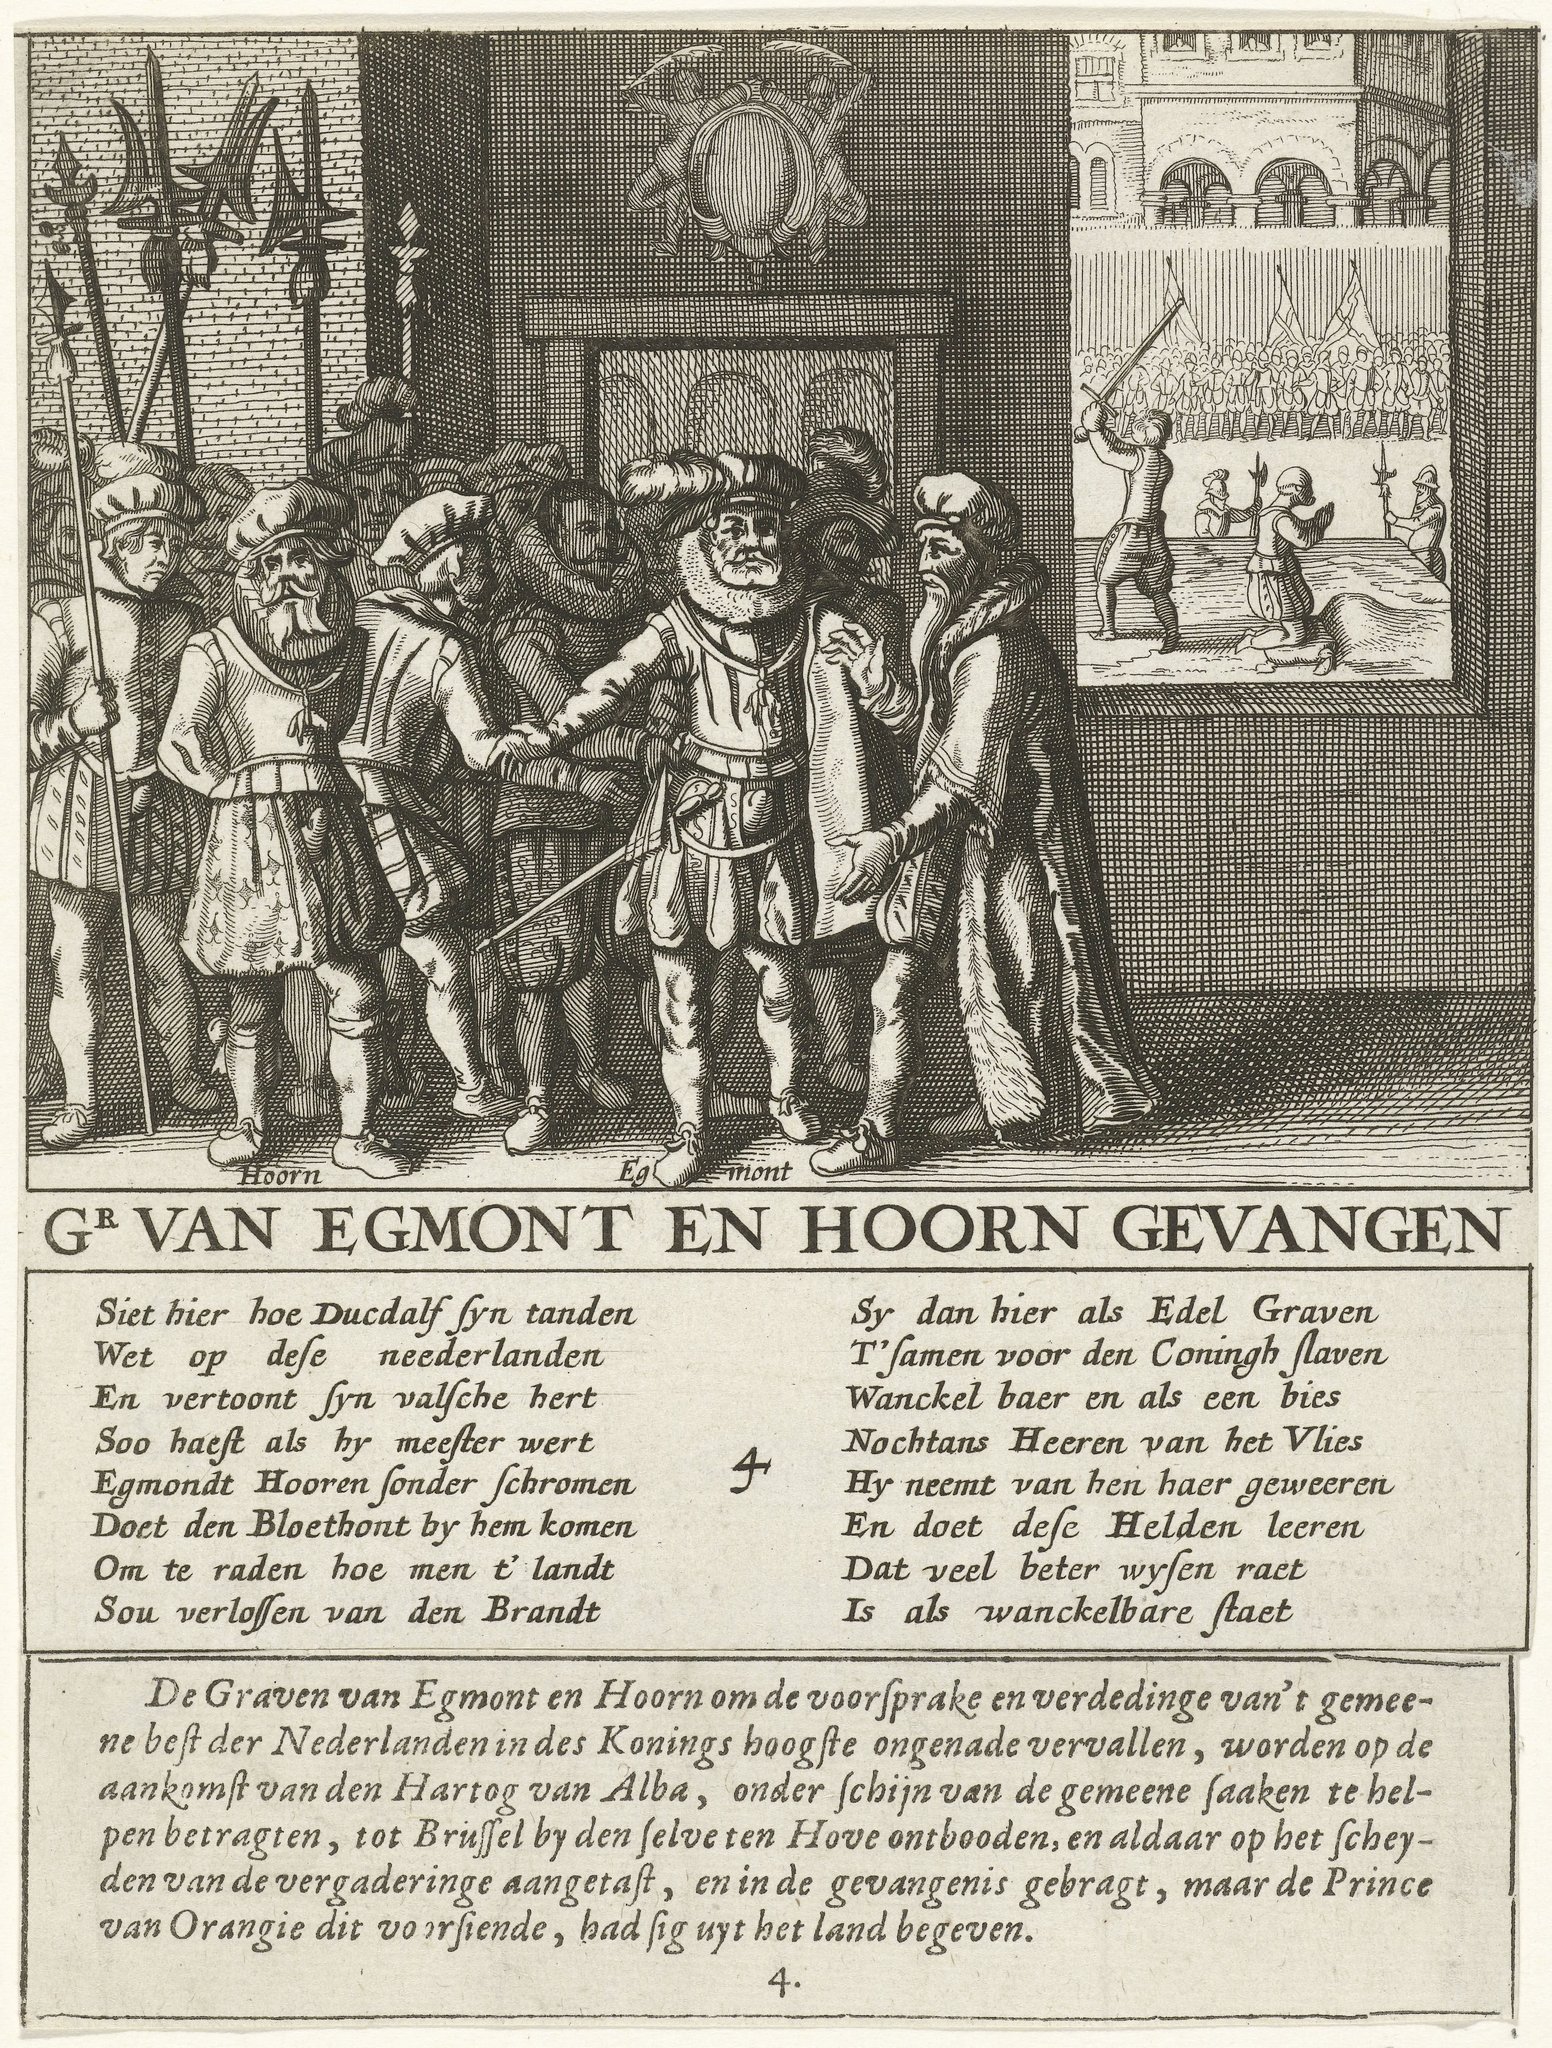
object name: print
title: De Spaensche Tiranye gheschiet in Nederlant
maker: Anonymous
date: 1618-1624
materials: paper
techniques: etching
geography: northern netherlands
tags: fernando álvarez de toledo (3rd duke of alba), brussels, earl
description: Illustratie voor een (onbekende) uitgave van het populaire en vaak herdrukte werk getiteld: De Spaensche Tiranye gheschiet in Nederlant, waarschijnlijk voor het eerst ca. 1620 verschenen. Zie ook Hollstein (Dutch), vol. XXXVIII (Claes Jansz. Visscher II), p. 165, nr. 425 en een andere versie van dit werk uitgegeven in 1621 te Amsterdam bij C.L. vander Plasse, in de collectie van de Rijksmuseum Research Library, signatuur 327 K 30.